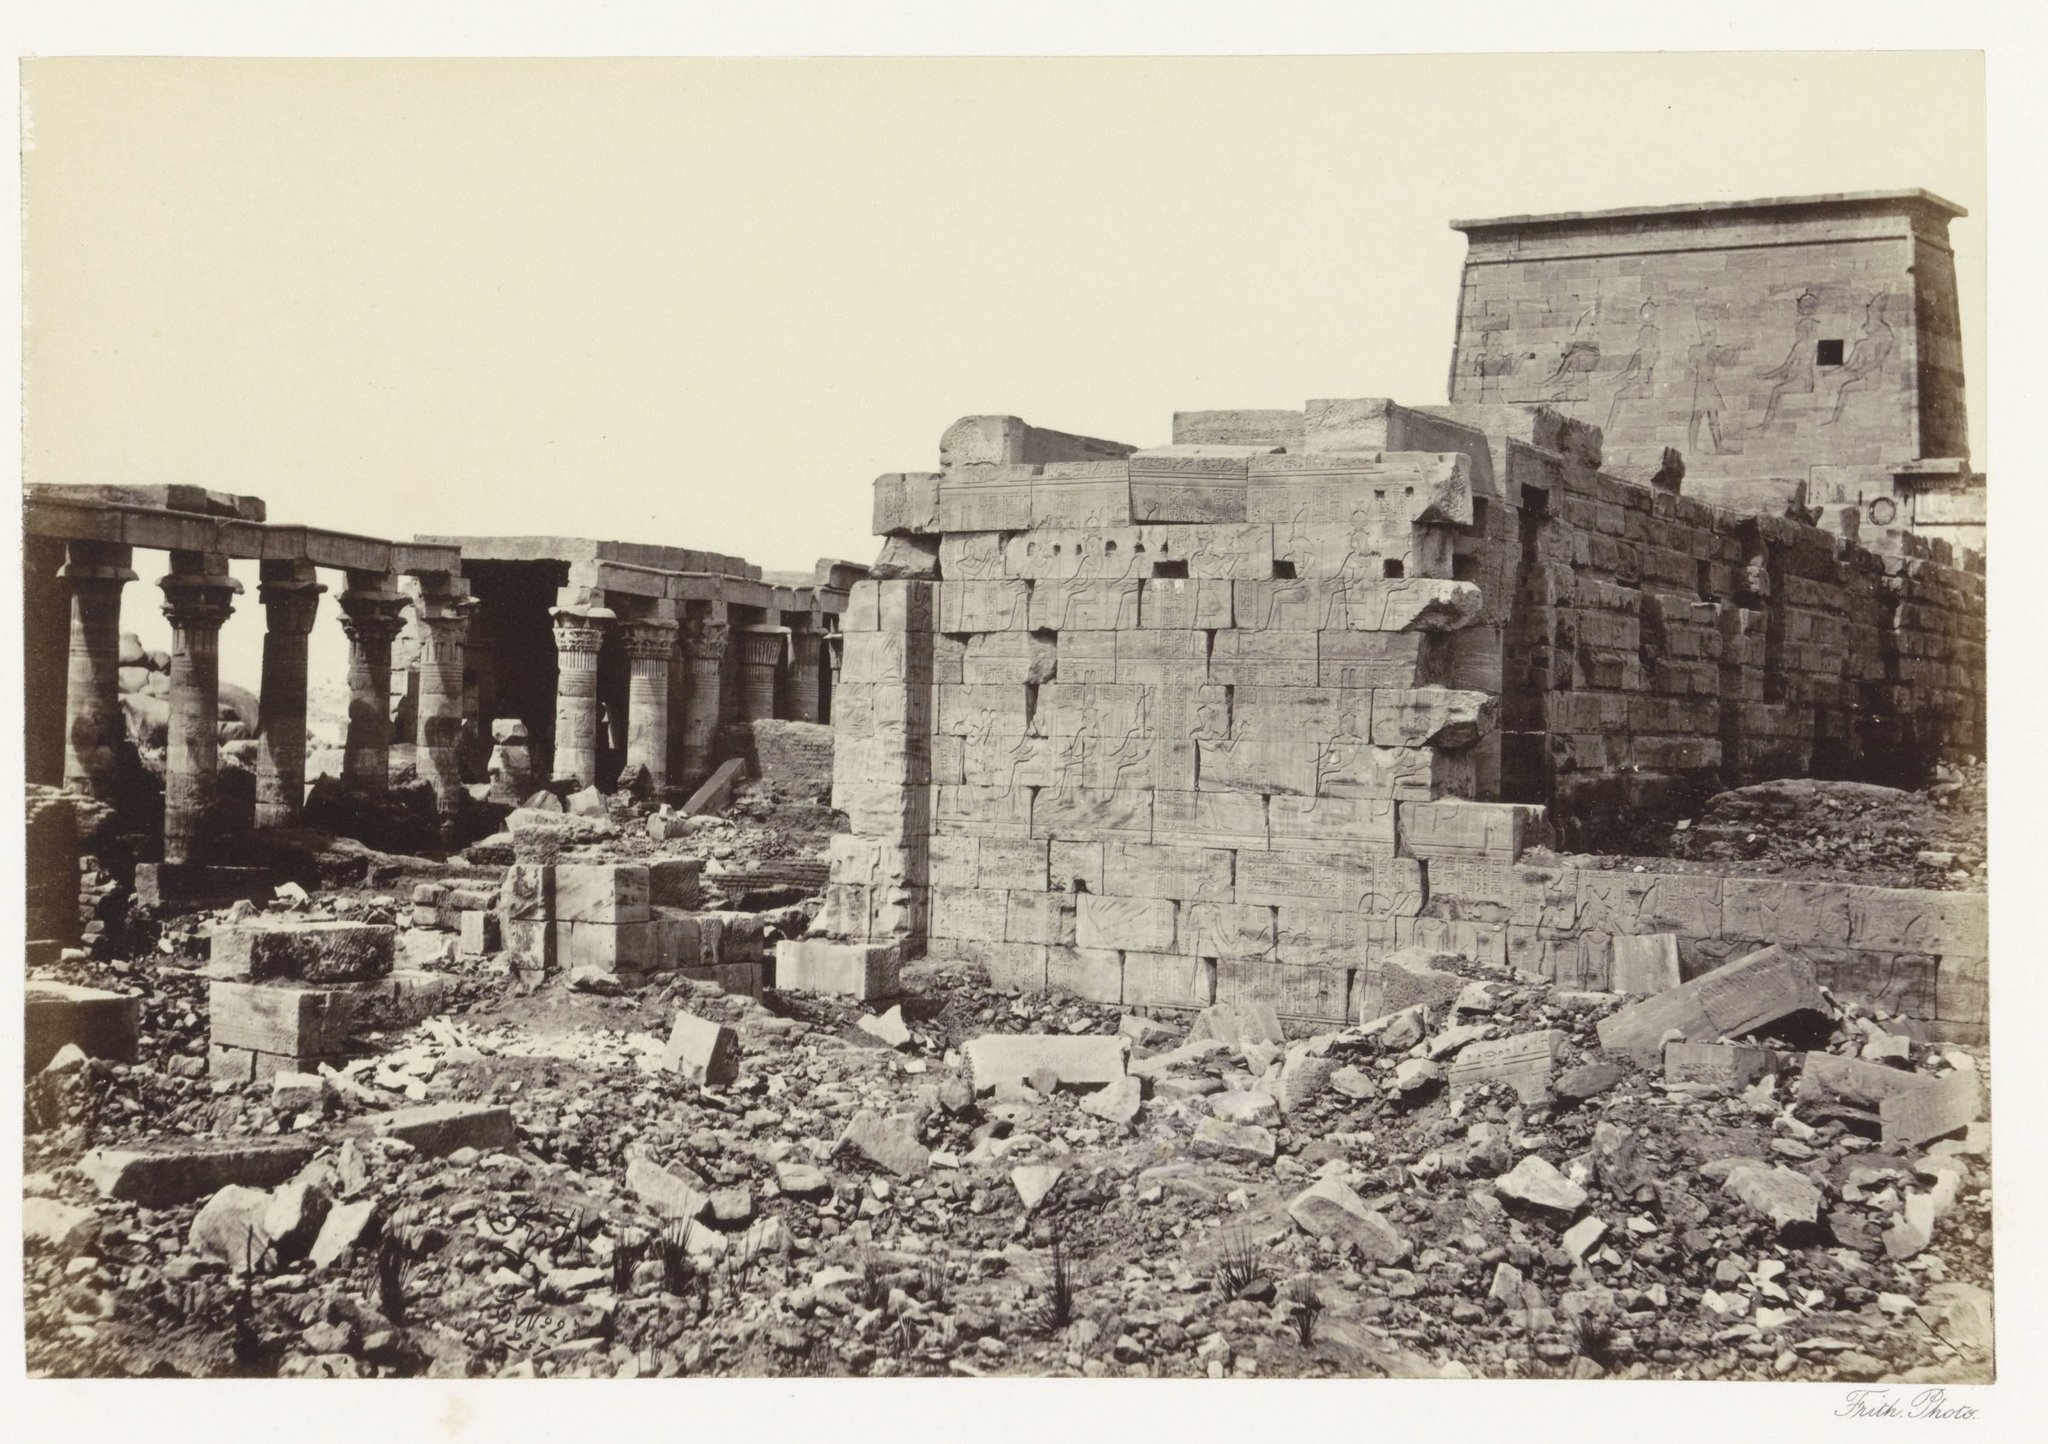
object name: page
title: View on the island of Philae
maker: francis frith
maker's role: publisher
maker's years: 1822-1898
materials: paper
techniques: albumen print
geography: philae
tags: island, temple, shrine ~ egyptian religion, colonnade